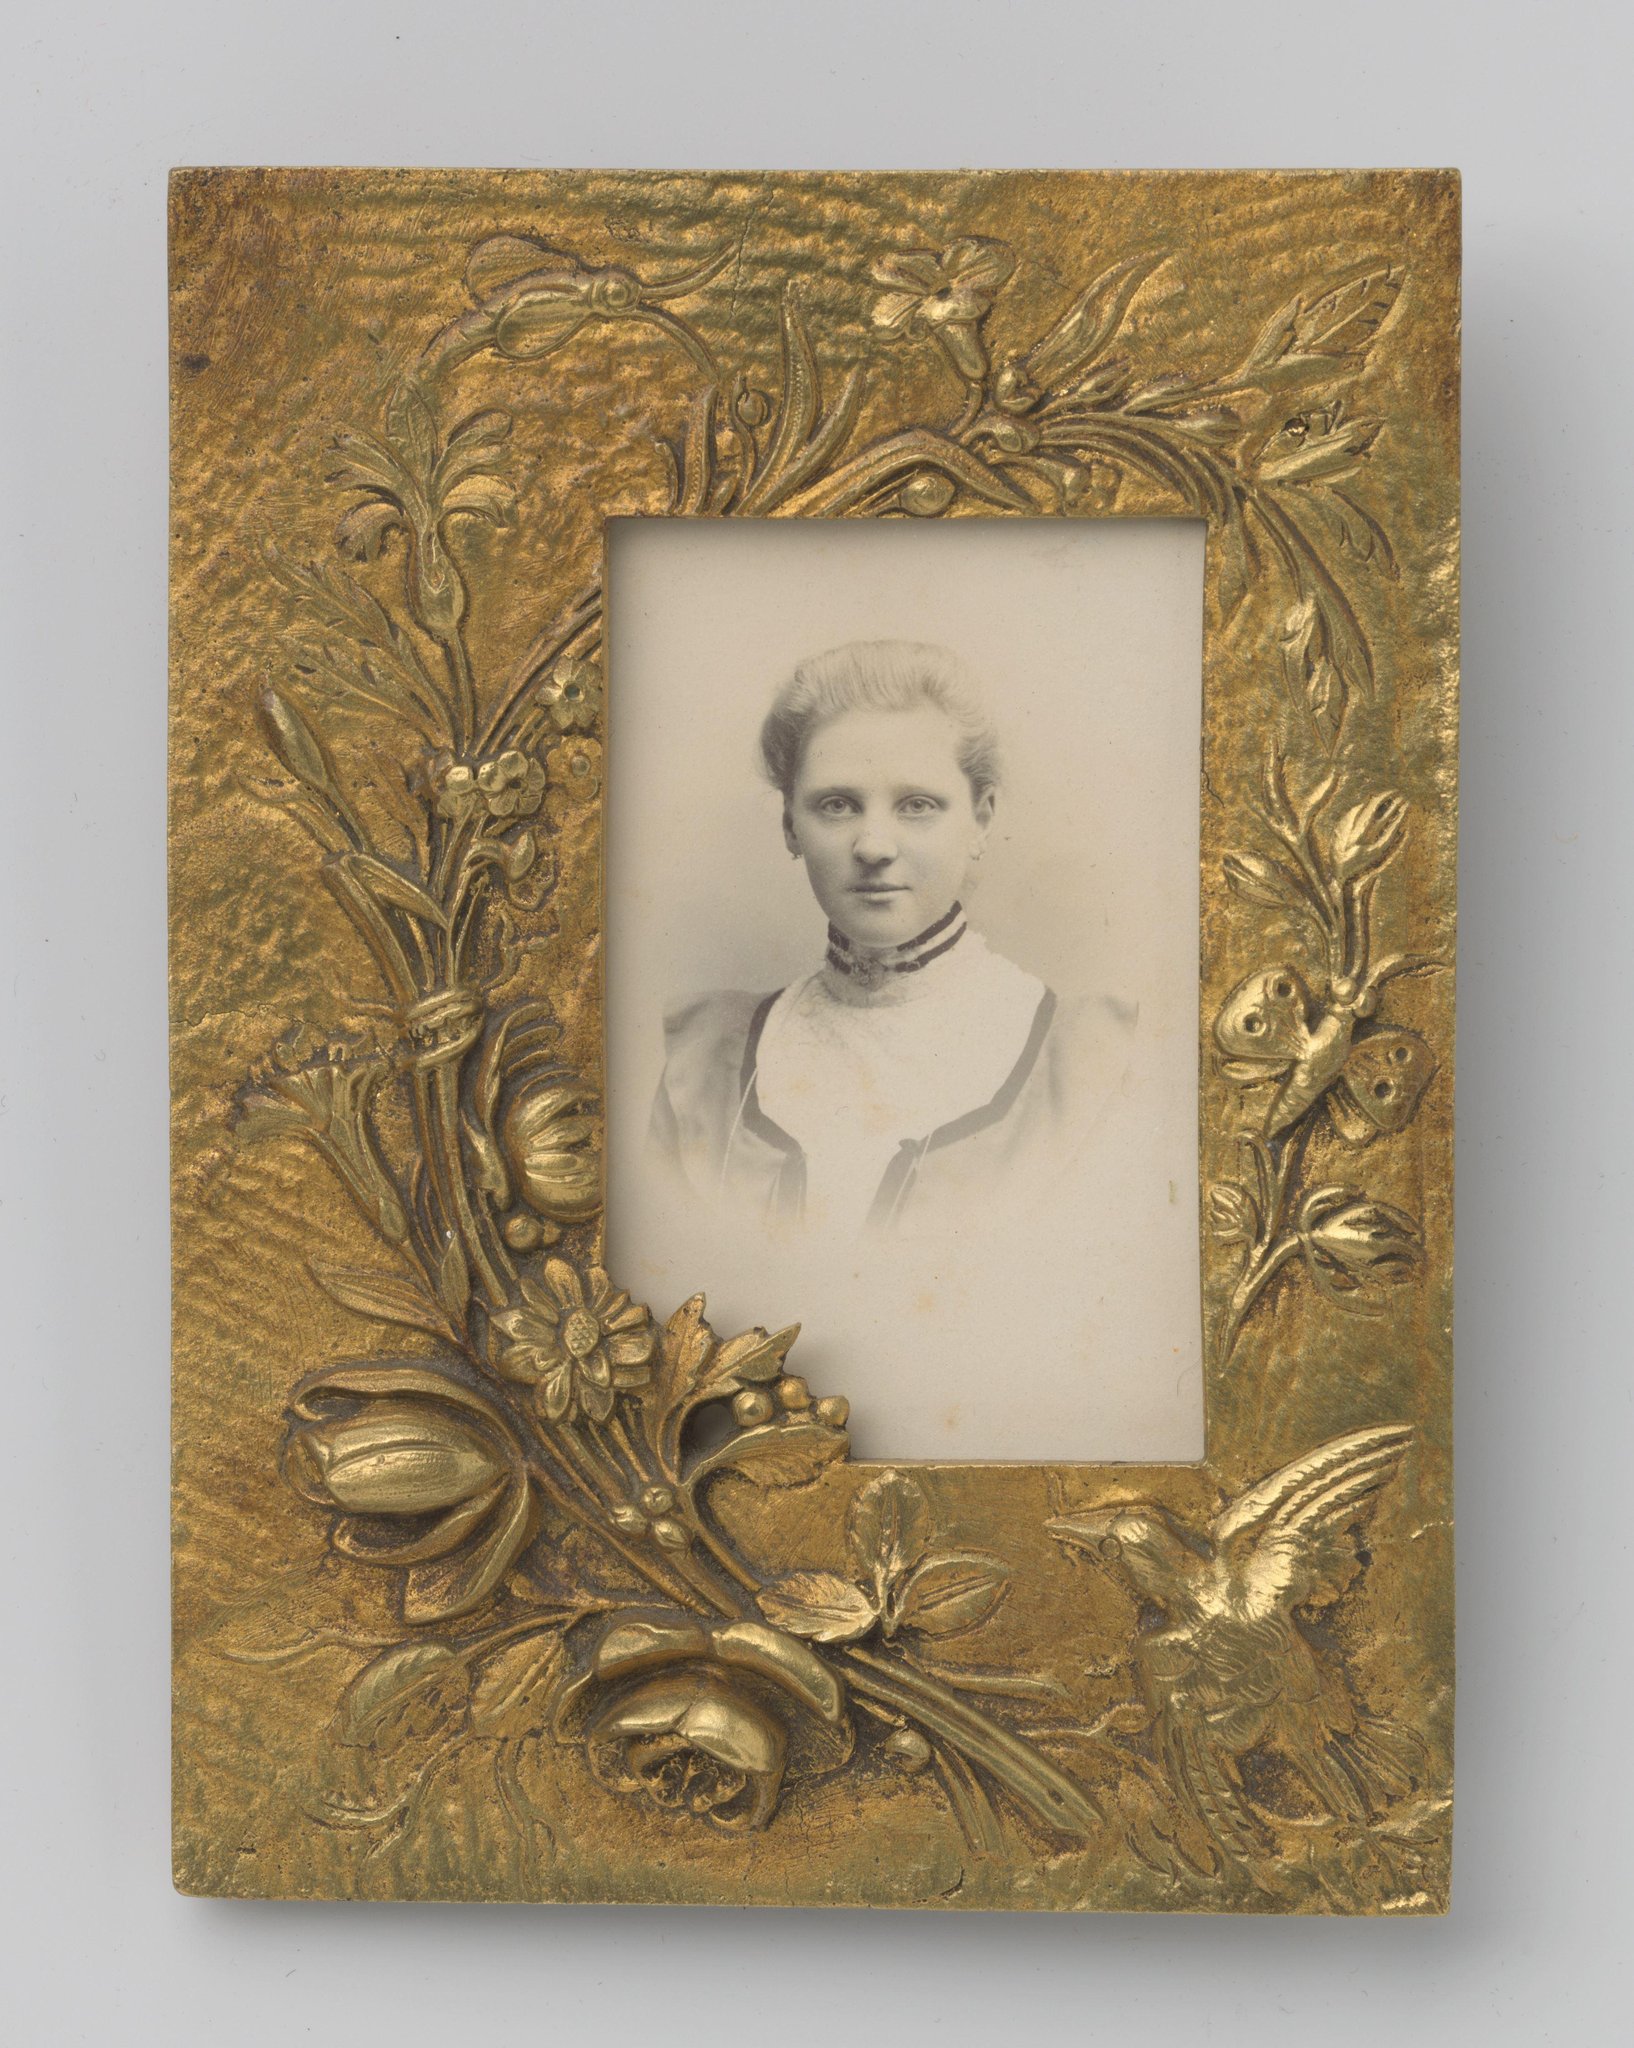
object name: frame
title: Portret van een onbekende jonge vrouw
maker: Anonymous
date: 1880-1900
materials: paper, glass, metal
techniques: matte daylight collodion silver print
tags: adolescent, young woman, maiden, anonymous historical person portrayed